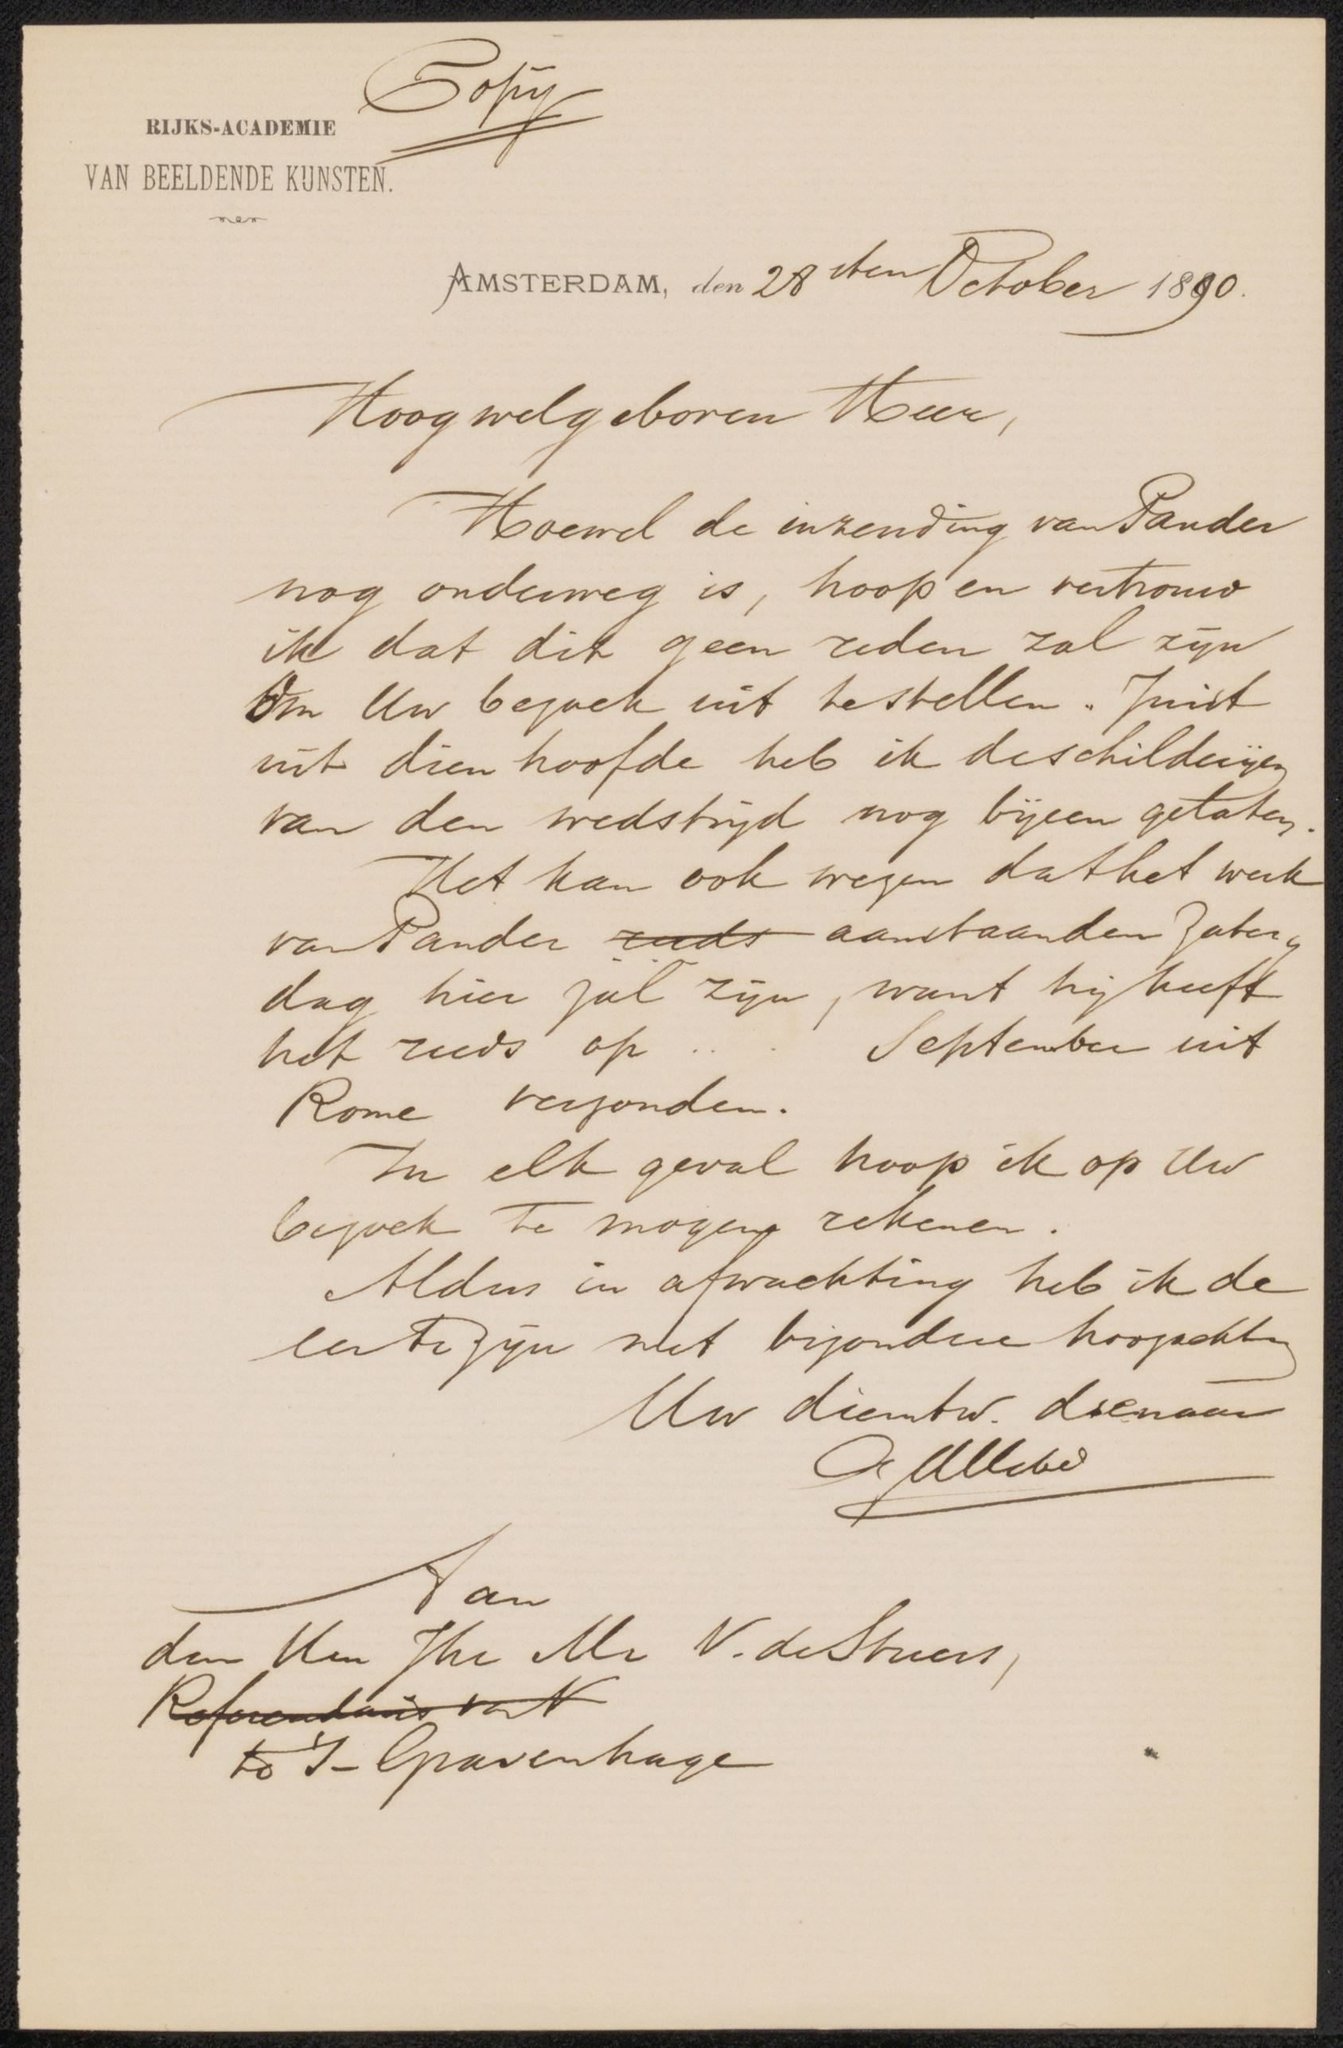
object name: letter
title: Brief aan jonkheer Victor Eugène Louis de Stuers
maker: august allebé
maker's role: draughtsman, print maker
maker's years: 1838-1927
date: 1890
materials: ink, paper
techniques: pen, printing, writing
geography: amsterdam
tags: maastricht, the hague, print maker, draughtsman, jonkheer victor eugène louis de stuers, rome, designer, sculptor, pier pander, distribution of awards ~ art contest, painting (including book-illumination, miniature-painting)